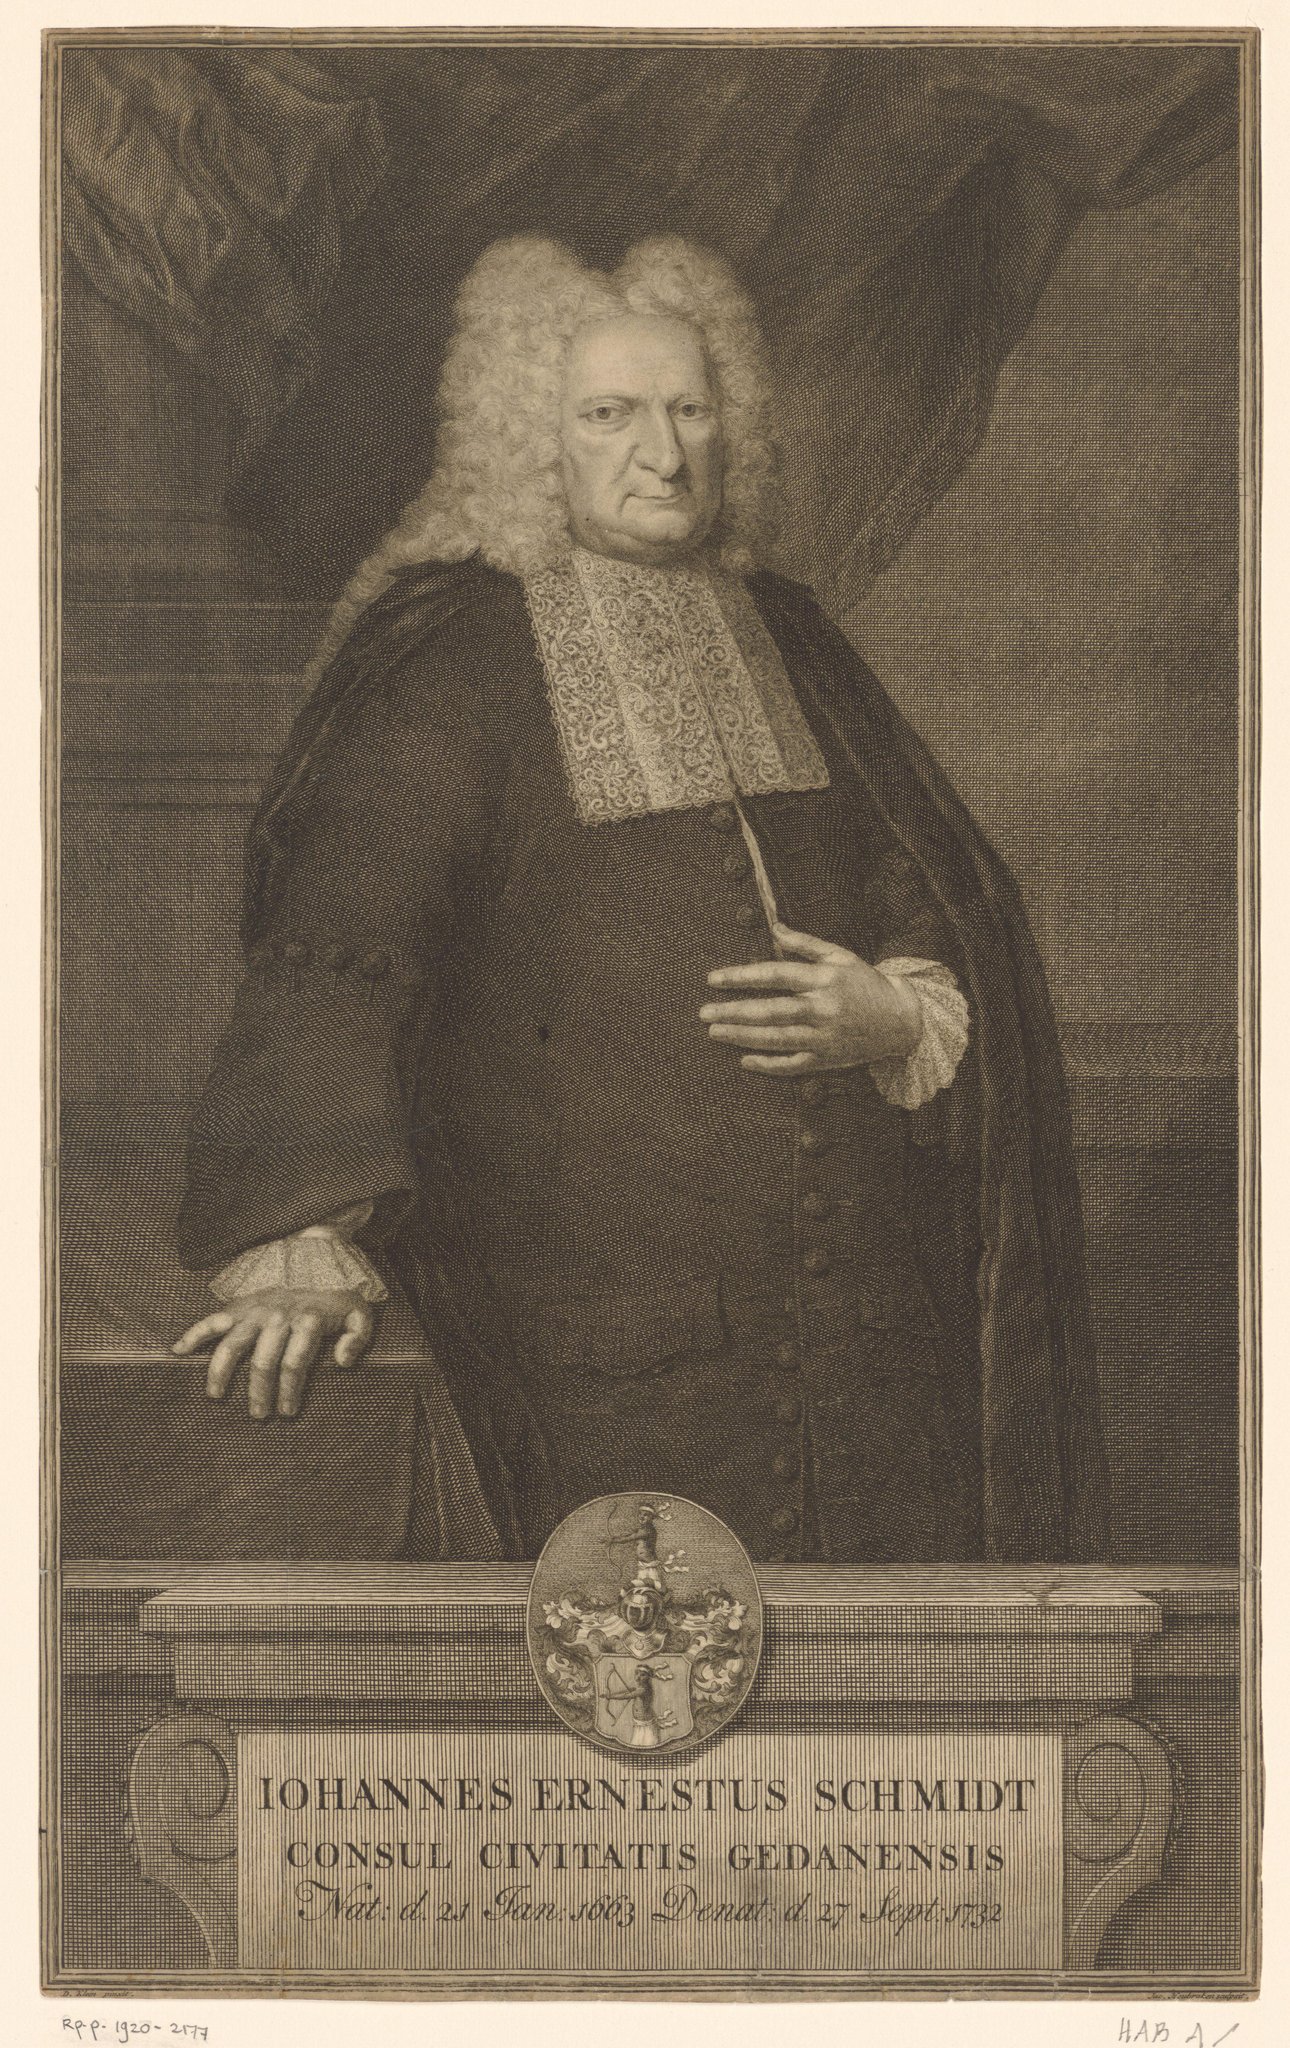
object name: print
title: Iohannes Ernestus Schmidt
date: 1732-1780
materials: paper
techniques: engraving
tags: historical persons, armorial bearing, heraldry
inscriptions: collector's mark: Lugt 2228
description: Kniestuk naar rechts van Johannes Ernestus Schmidt, met zijn rechterhand leunend op een tafel naast hem. Op de achtergrond een zuil en een gordijn. Op de voorgrond een richel waarop een familiewapen en de naam en gegevens van de geportretteerde in drie regels in het Latijn.